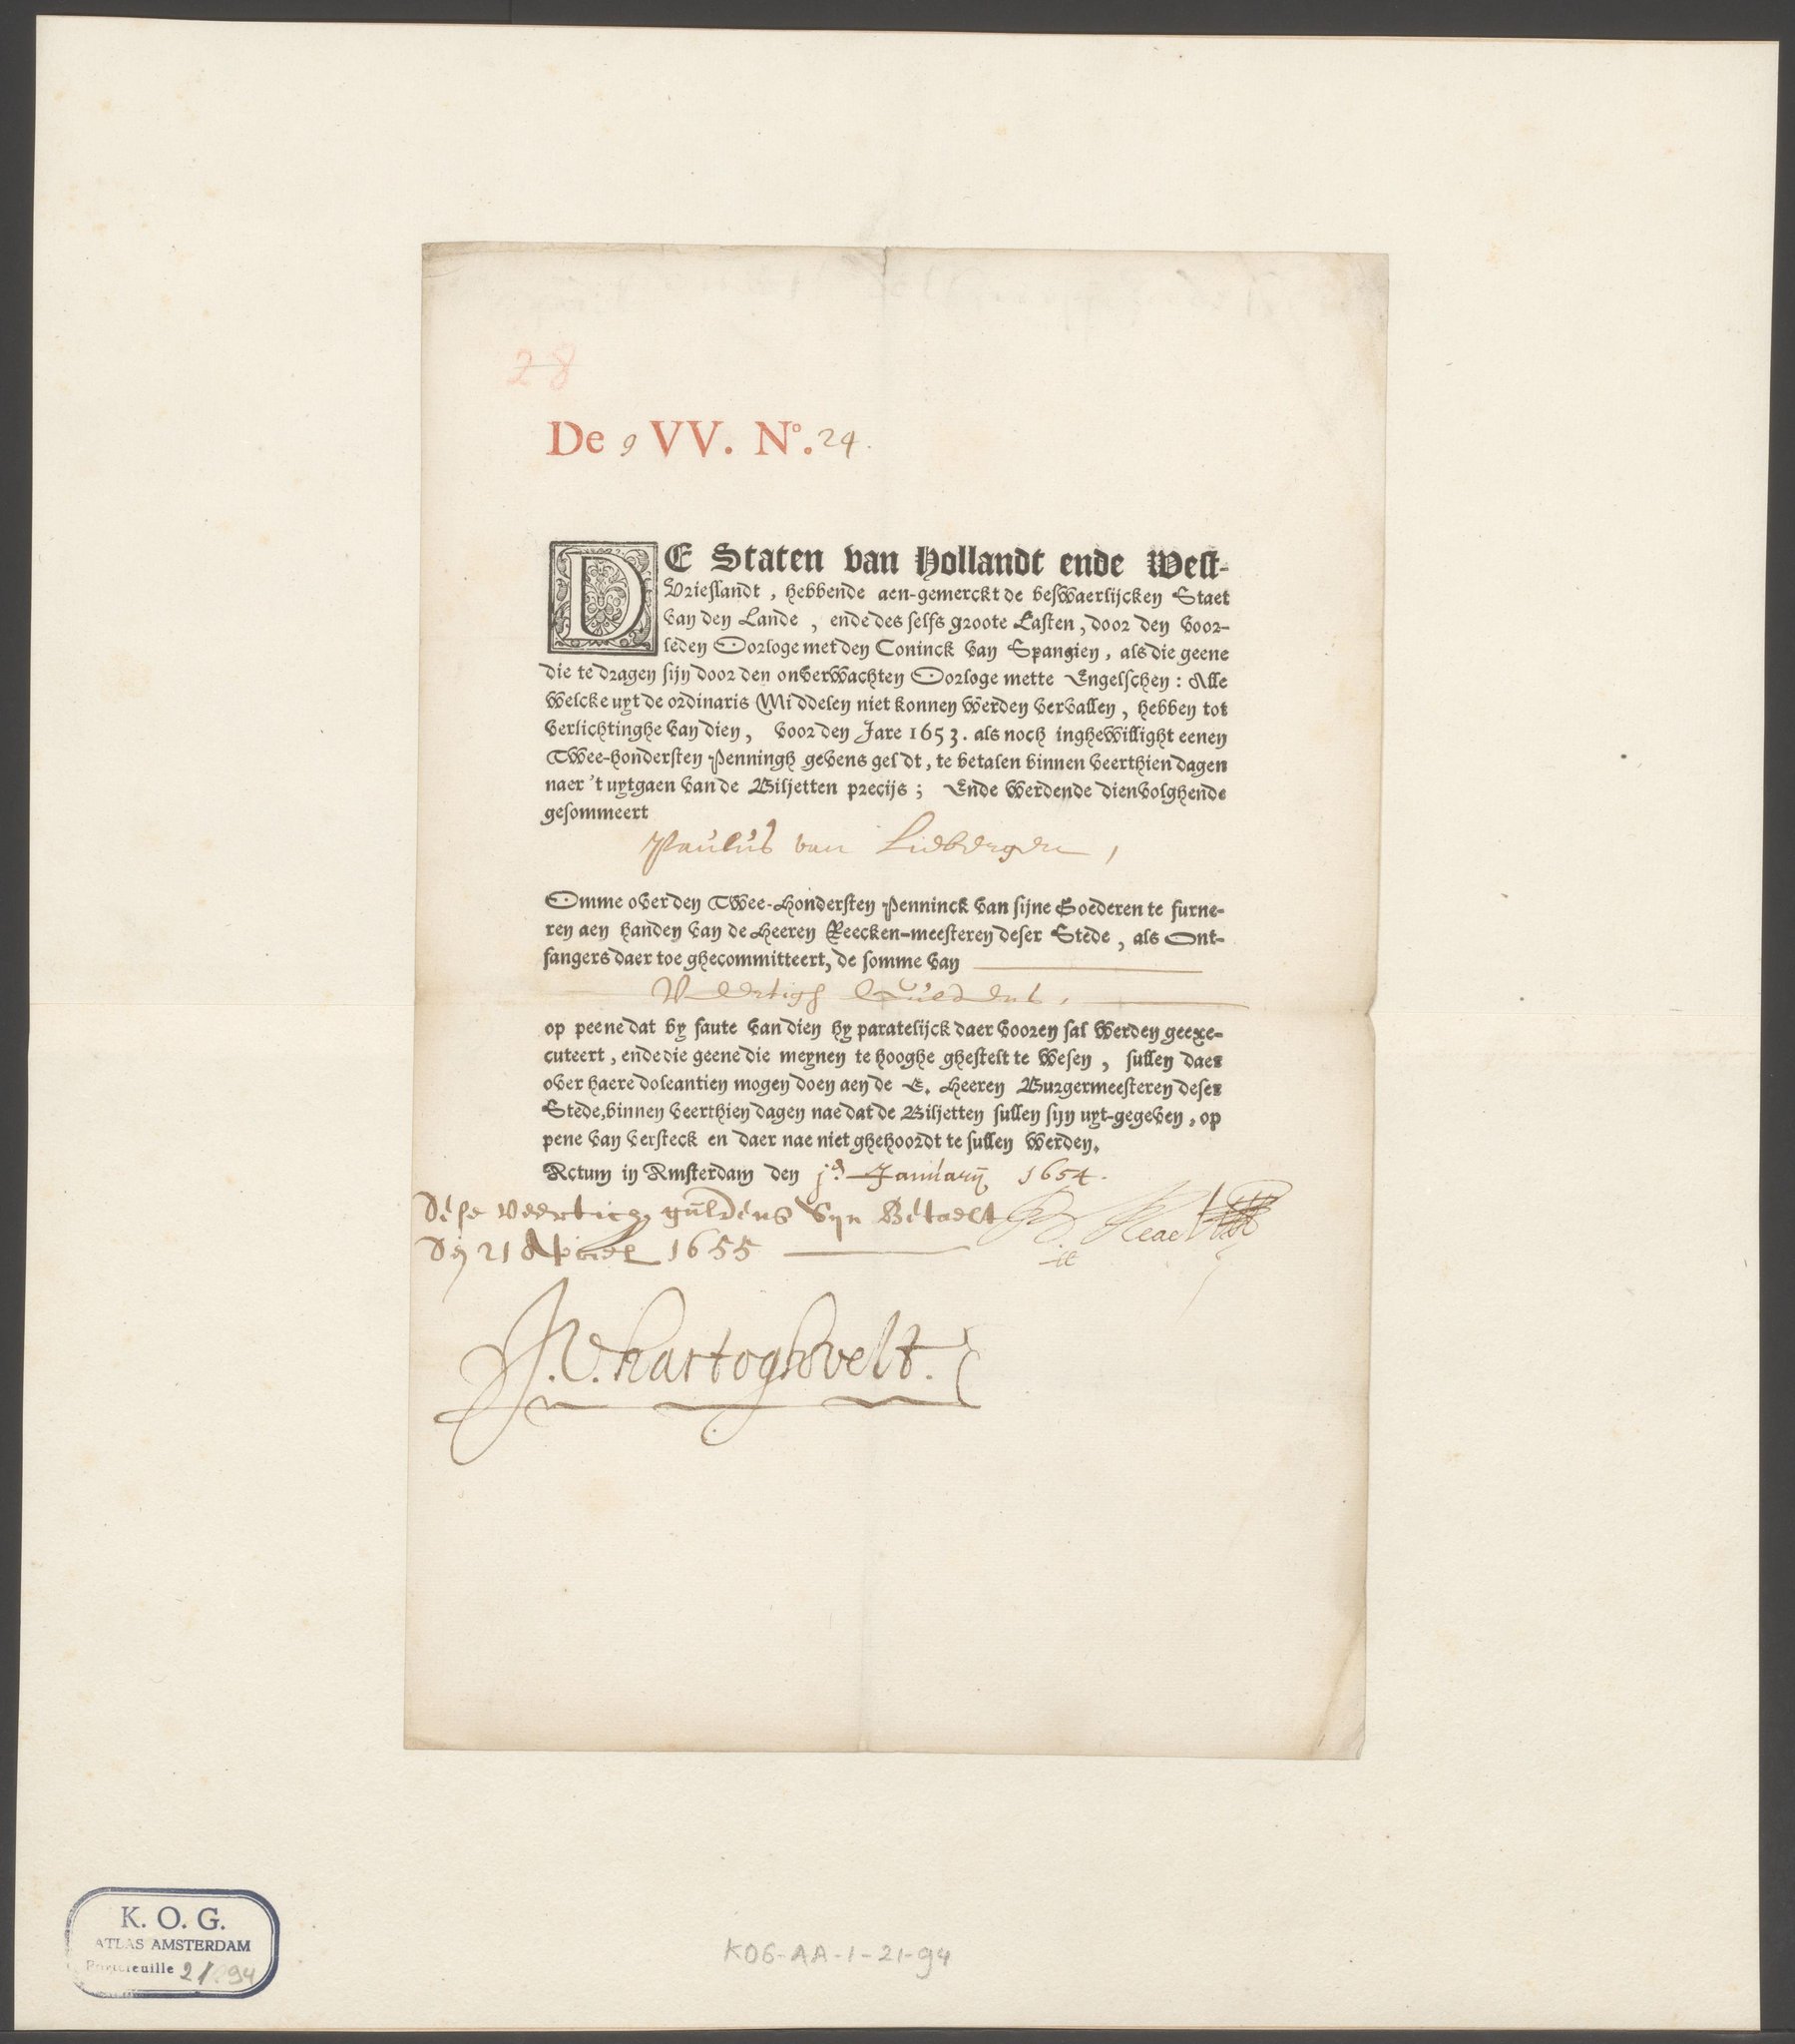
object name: document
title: Aanslagbiljet op naam van Paulus van Liebergen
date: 1655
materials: ink, paper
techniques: letterpress printing, pen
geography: amsterdam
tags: tax collection, tax payment, amsterdam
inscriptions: collector's mark: Lugt 1641b, inscription: ‘28’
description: Inzake betaling van de tweehonderdste penning met schriftelijke aantekening dat deze is voldaan op 21 april 1655. Onderwerpsrubriek binnen de Atlas Amsterdam: Belastingen.